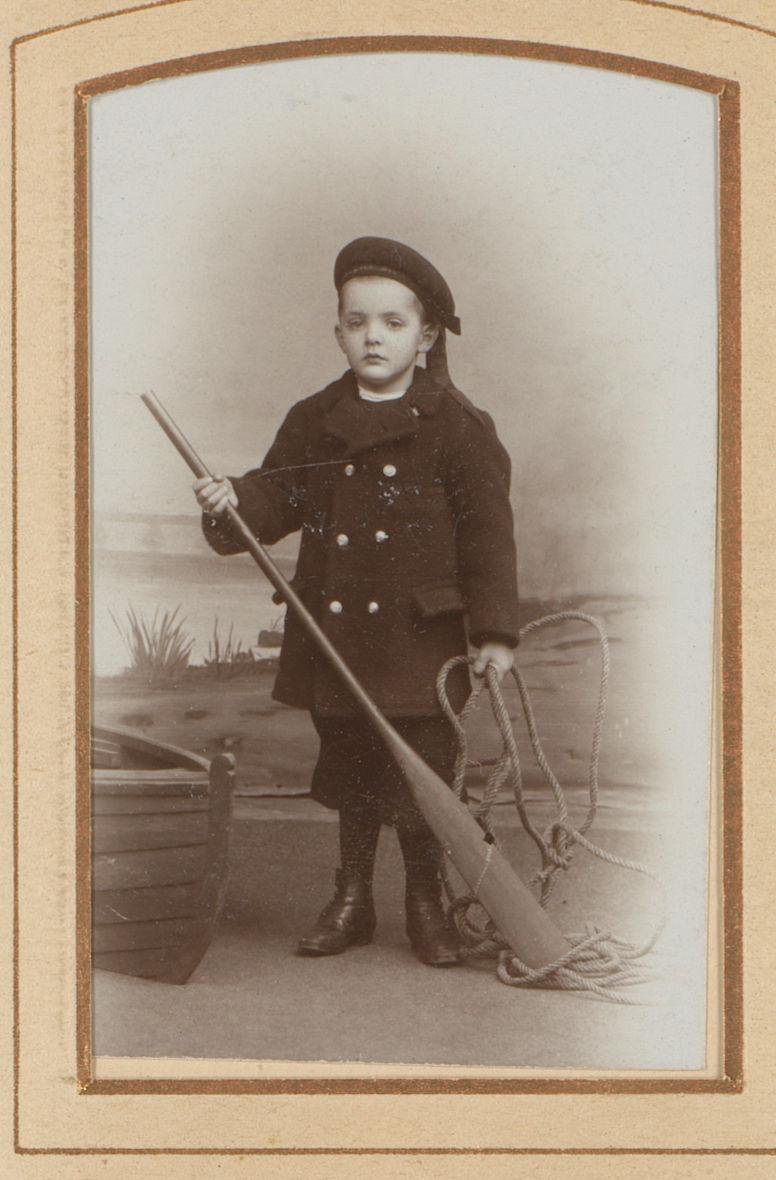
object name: photograph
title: Portret van een jongen met roeispaan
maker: Anonymous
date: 1890-1920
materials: cardboard, photographic support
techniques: collodion silver print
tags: boy (child between toddler and youth), rowing-boat, canoe, etc.